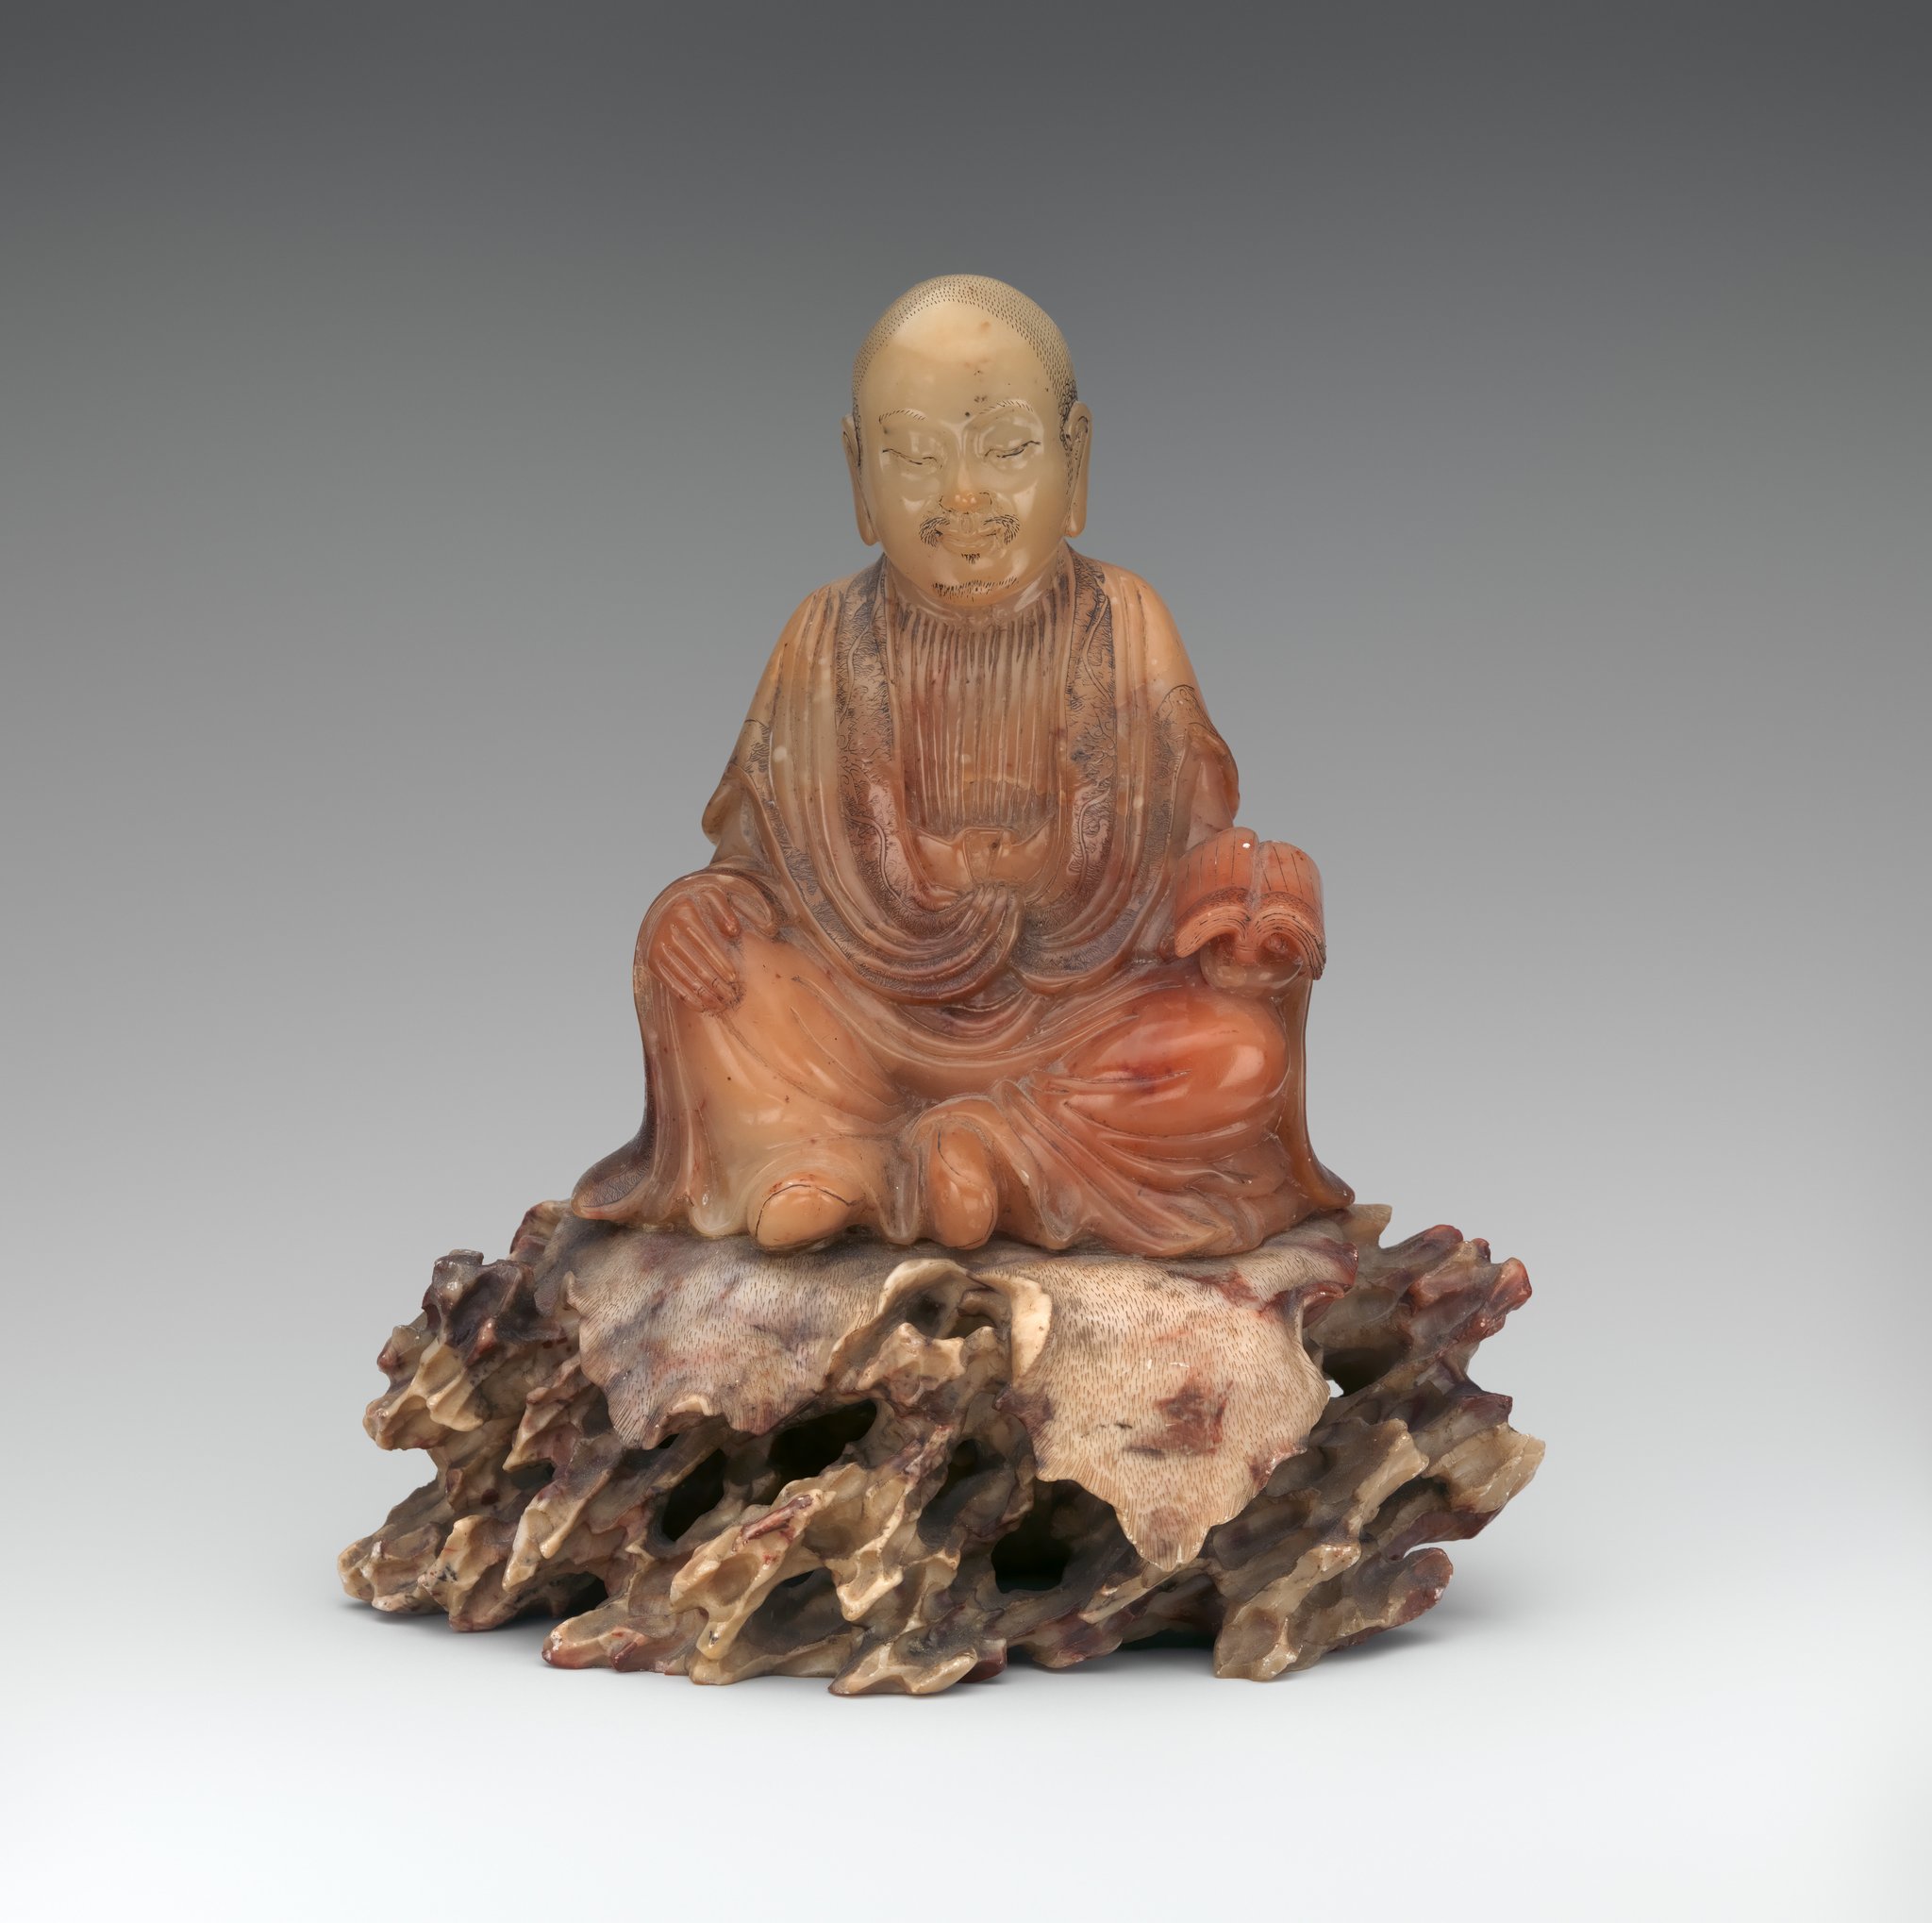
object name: figure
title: Seated luohan holding a book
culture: chinese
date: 1701-1800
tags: men,buddhism